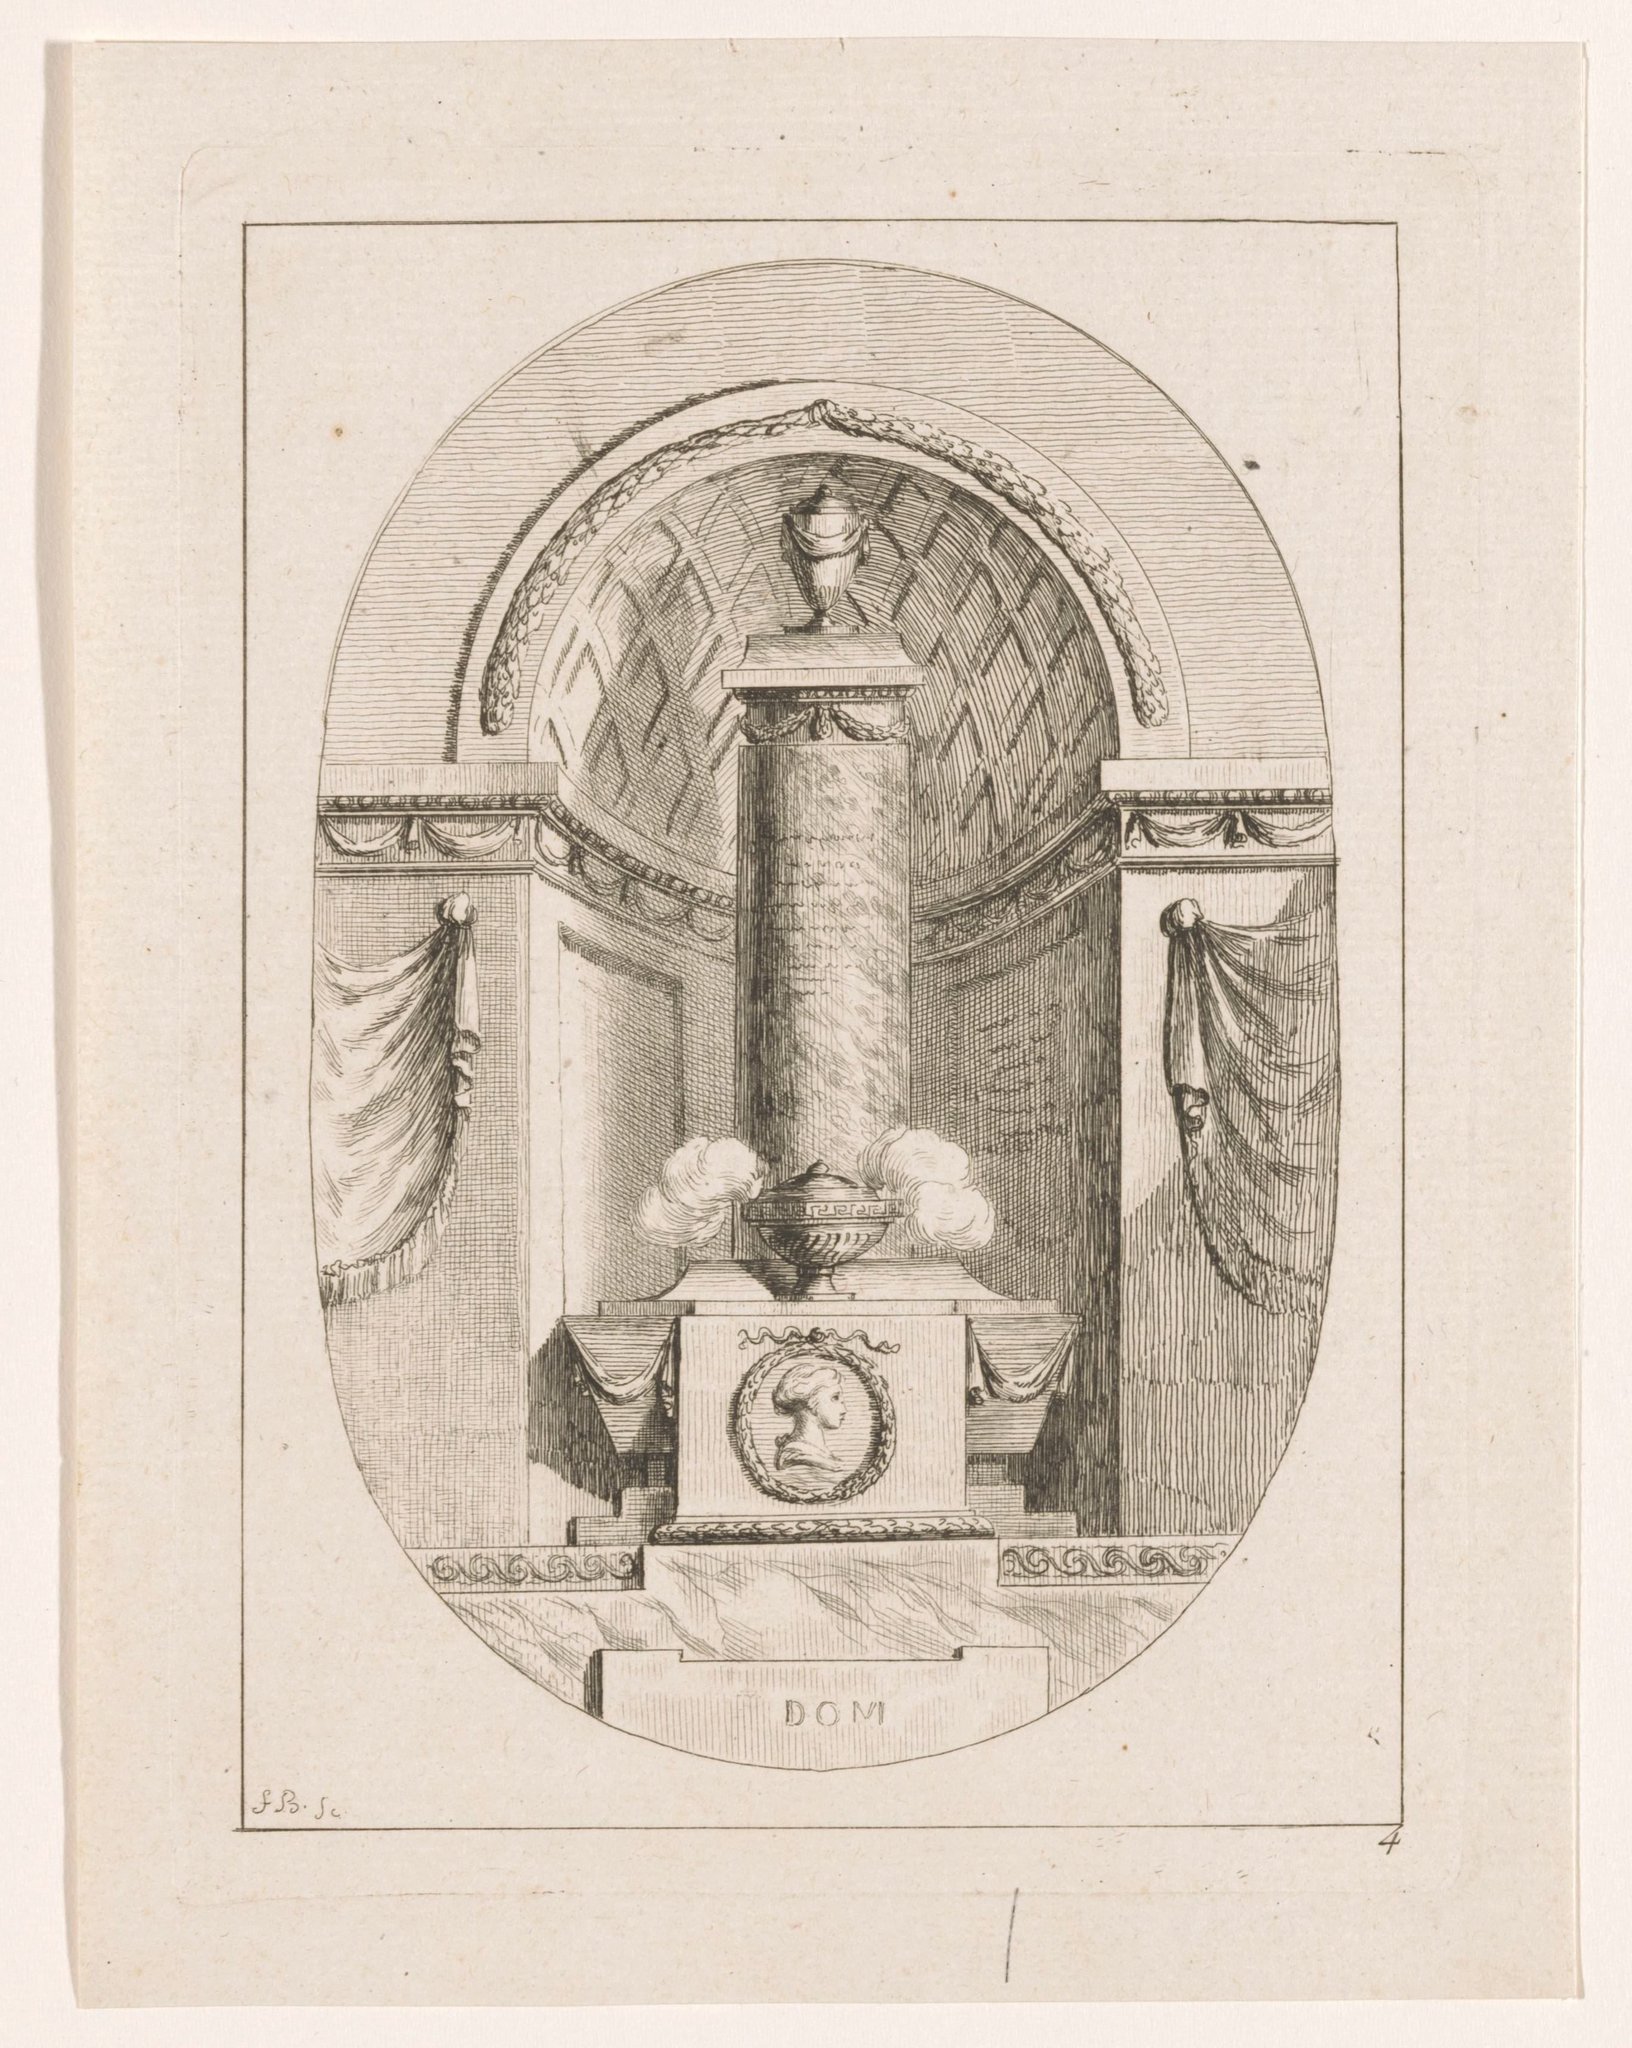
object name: print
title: Livre De Tombeaux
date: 1755-1782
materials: paper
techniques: etching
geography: paris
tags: niche-tomb, wall-tomb, column, pillar ~ architecture, incense-burner ~ scents, perfumes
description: Een tombe met een zuil in een halfronde nis, daarvoor een rookvat op een voetstuk.